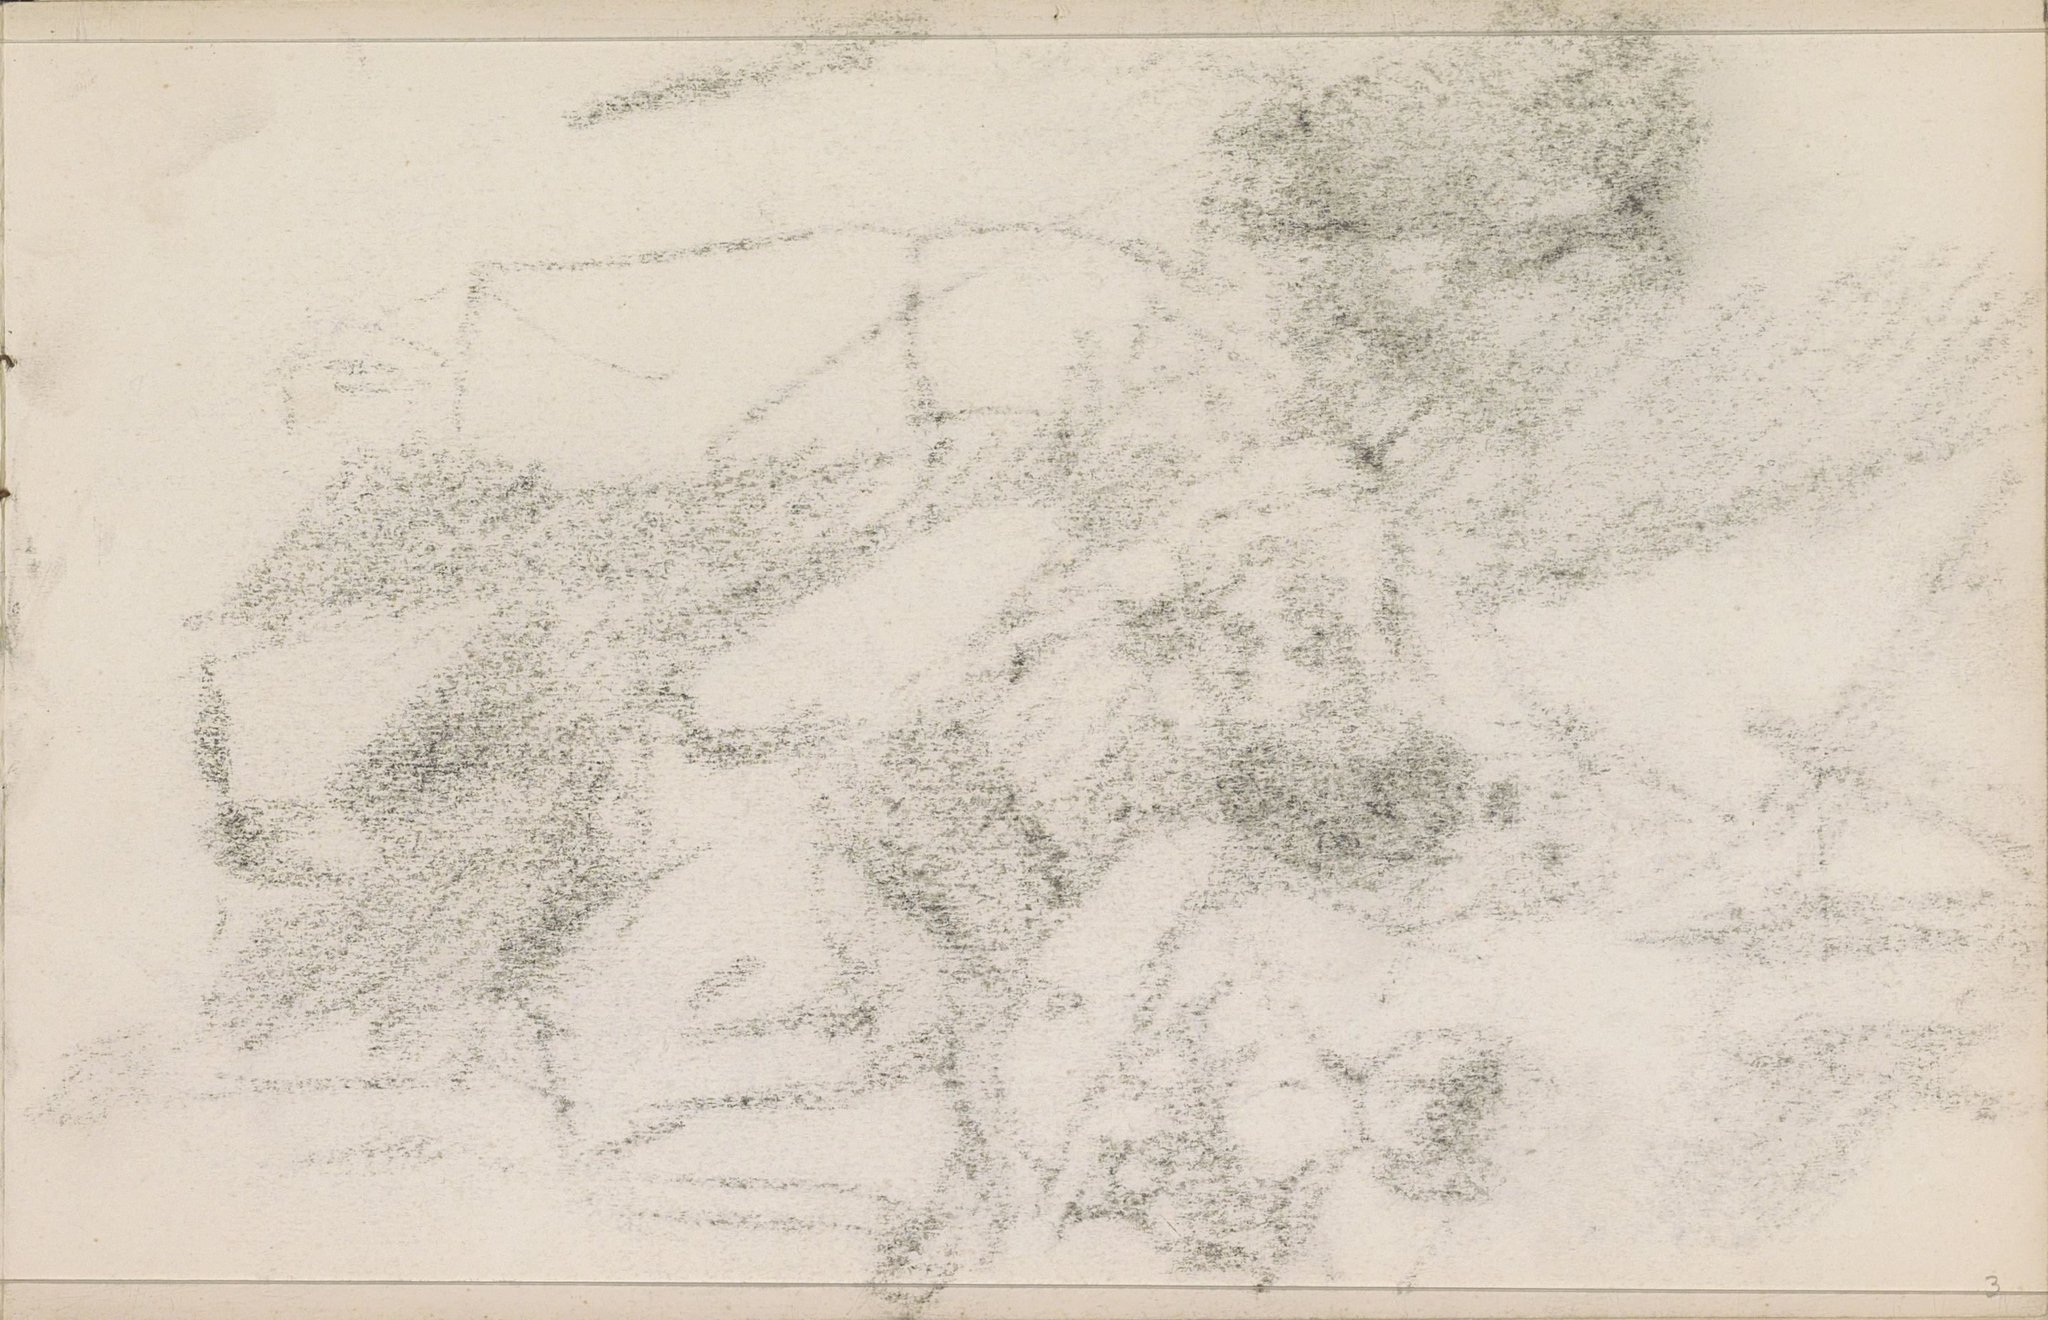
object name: sketchbook leaf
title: Abklatsch van de krijttekening op blad 2 verso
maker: isaac israels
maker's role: draughtsman, painter, print maker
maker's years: 1865-1934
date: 1875-1934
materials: paper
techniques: printmaking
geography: paris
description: Blad 3 recto uit schetsboek LI met 11 bladen.